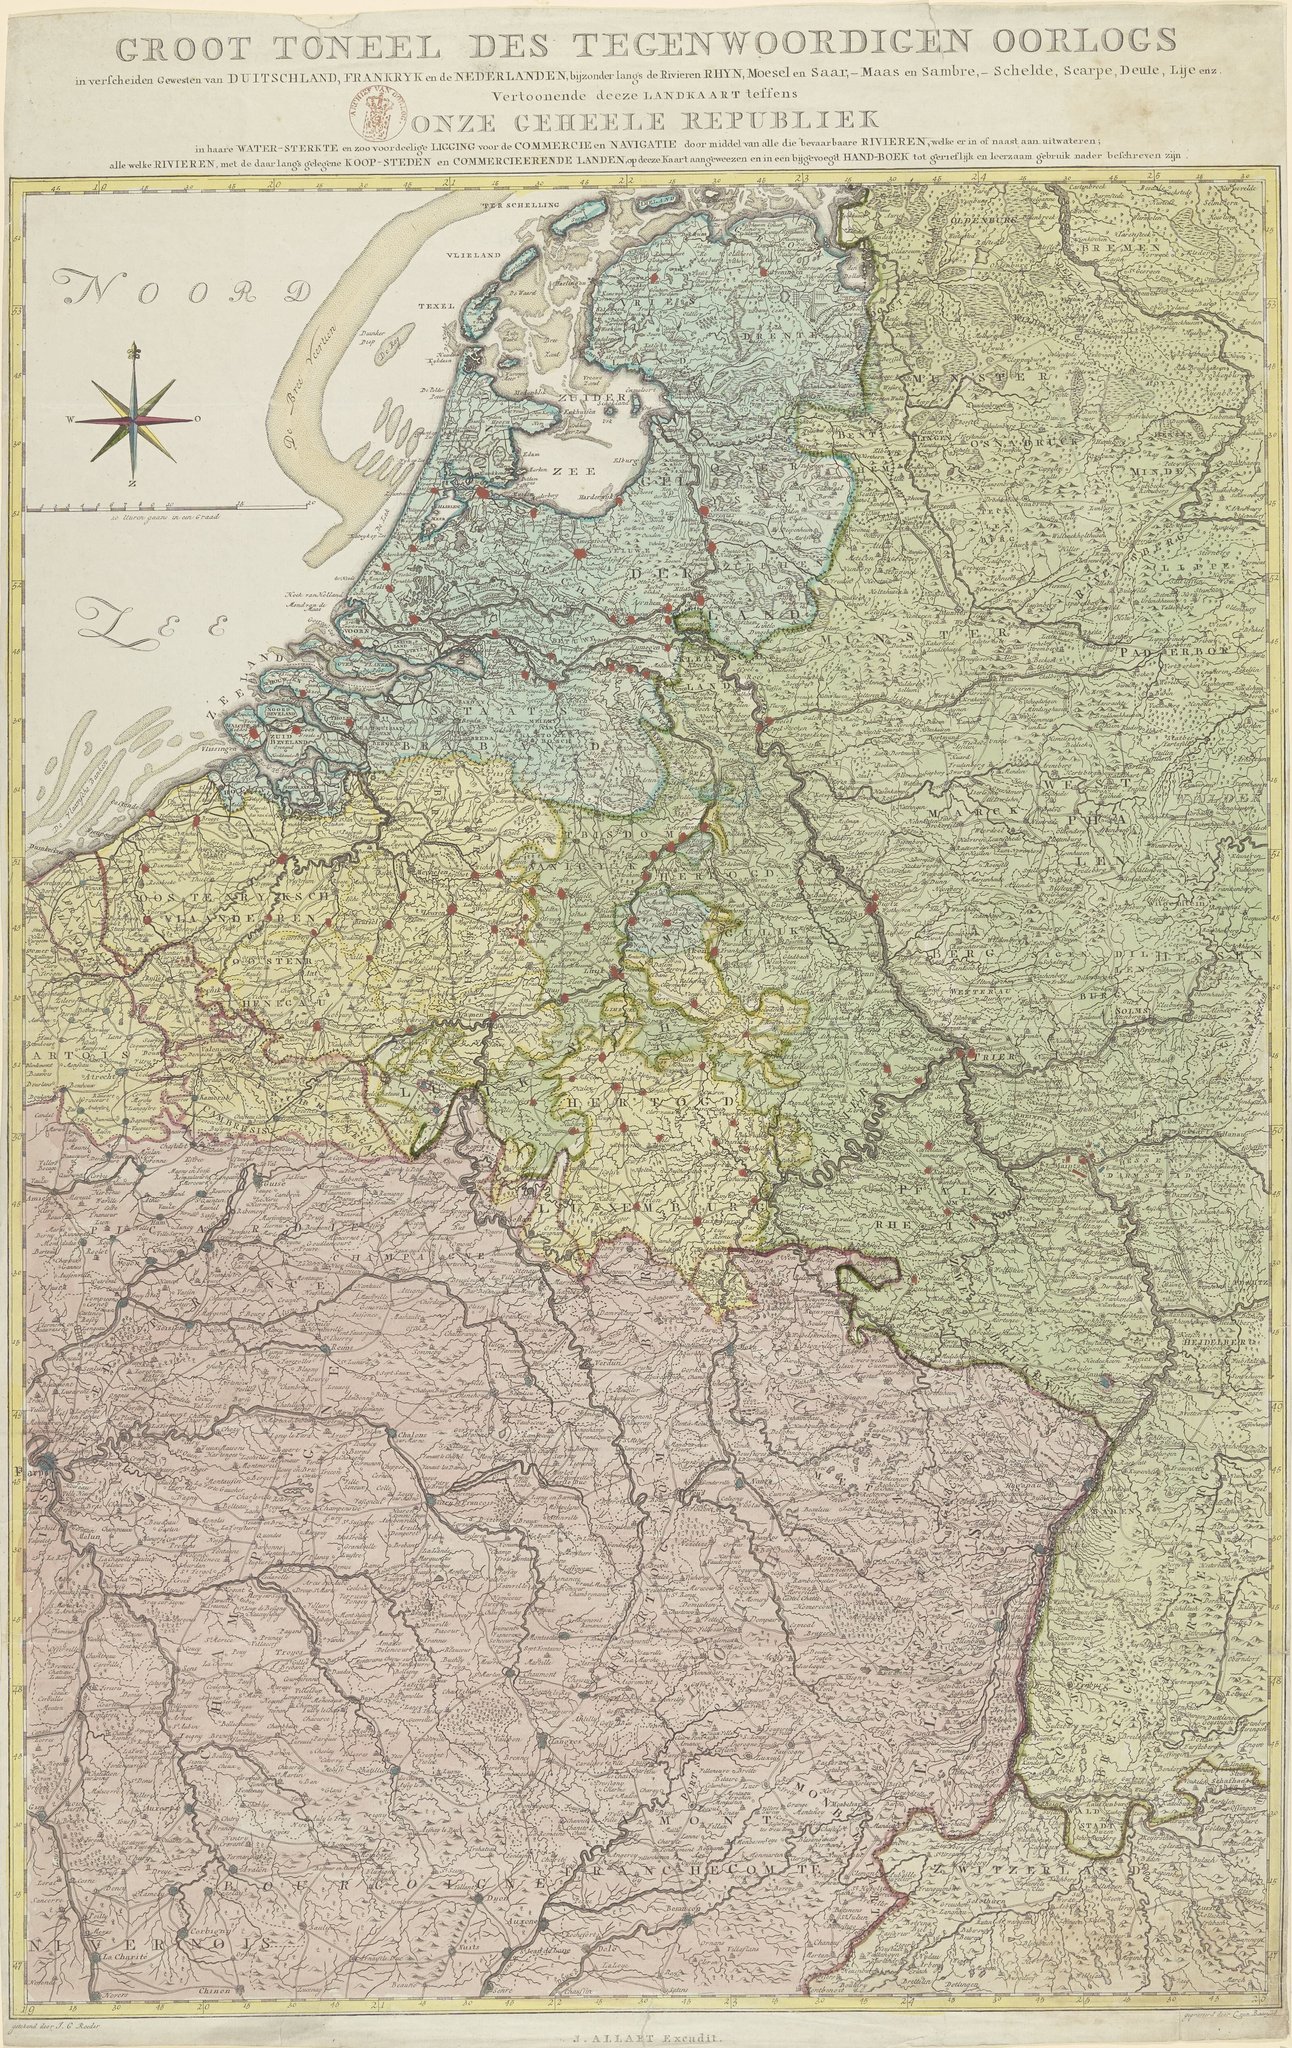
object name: map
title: Kaart van het oorlogstoneel in Nederland en omringende landen, ca. 1794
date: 1793-1795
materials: paper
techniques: engraving, etching, hand coloring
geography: amsterdam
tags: maps of separate countries or regions, netherlands, germany, france, belgium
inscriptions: collector's mark: Lugt 2228, collector's mark: Lugt 19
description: Kaart van het oorlogstoneel van de Eerste Coaltitieoorlog in de Republiek en de Oostenrijkse Nederlanden, Luxemburg en het westen van Duitsland, 1794. De kaart loopt tot aan Parijs en Zwitserland.